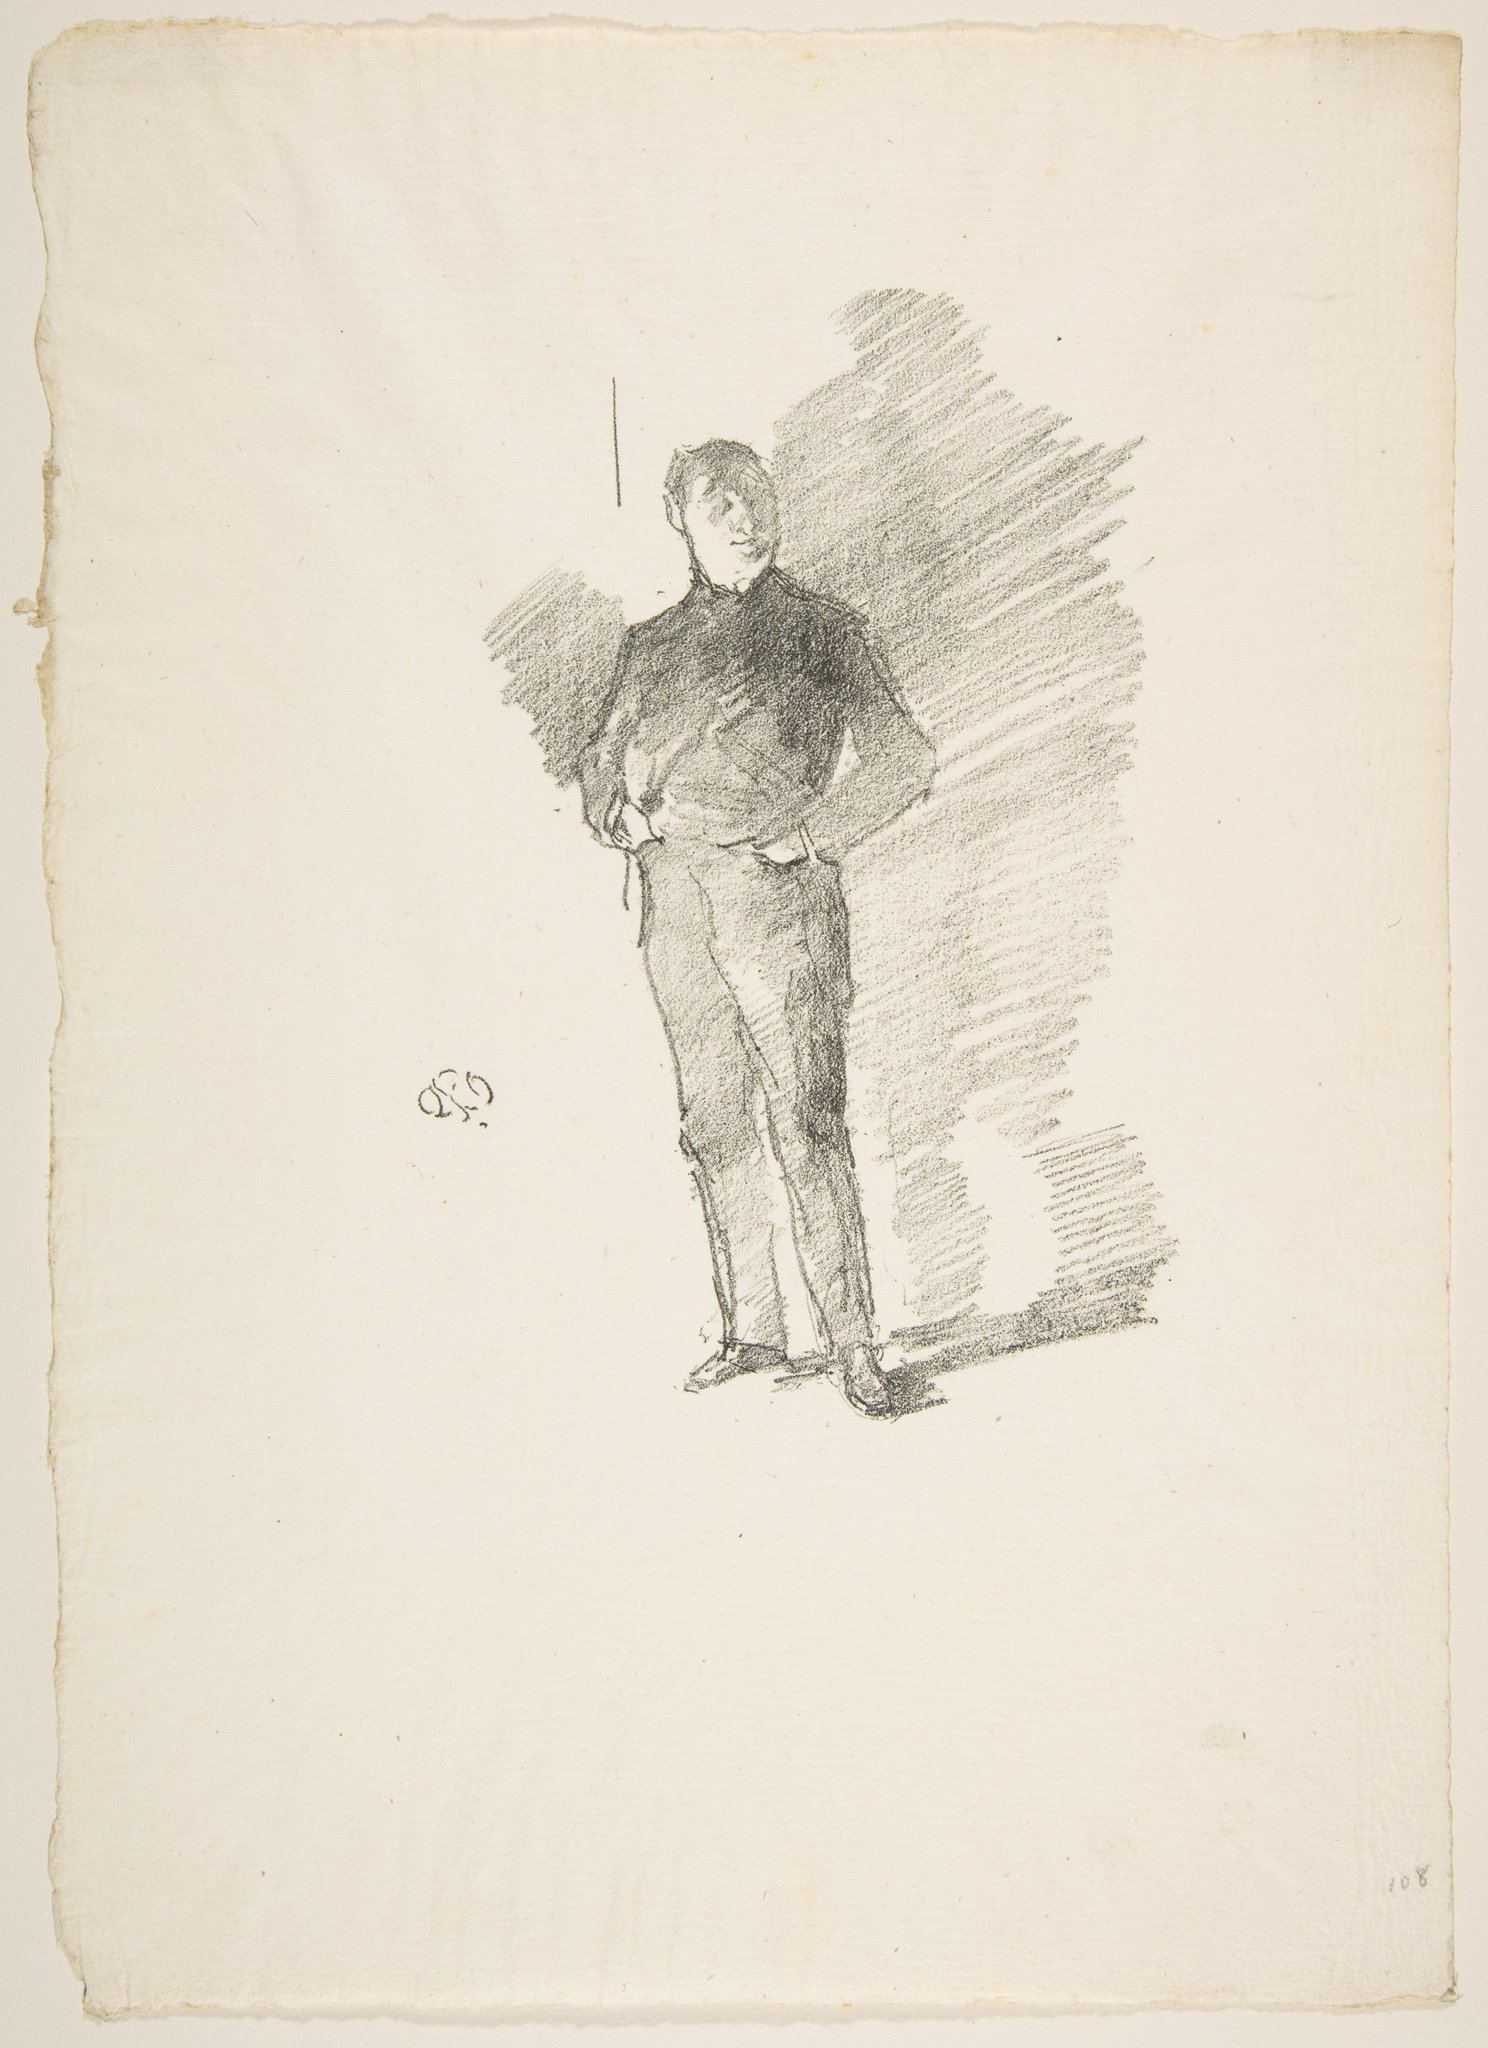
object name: print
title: Study No. 2: Mr. Thomas Way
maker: james mcneill whistler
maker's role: artist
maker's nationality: american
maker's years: 1834-1903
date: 1896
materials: ink, paper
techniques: printing, lithography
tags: men